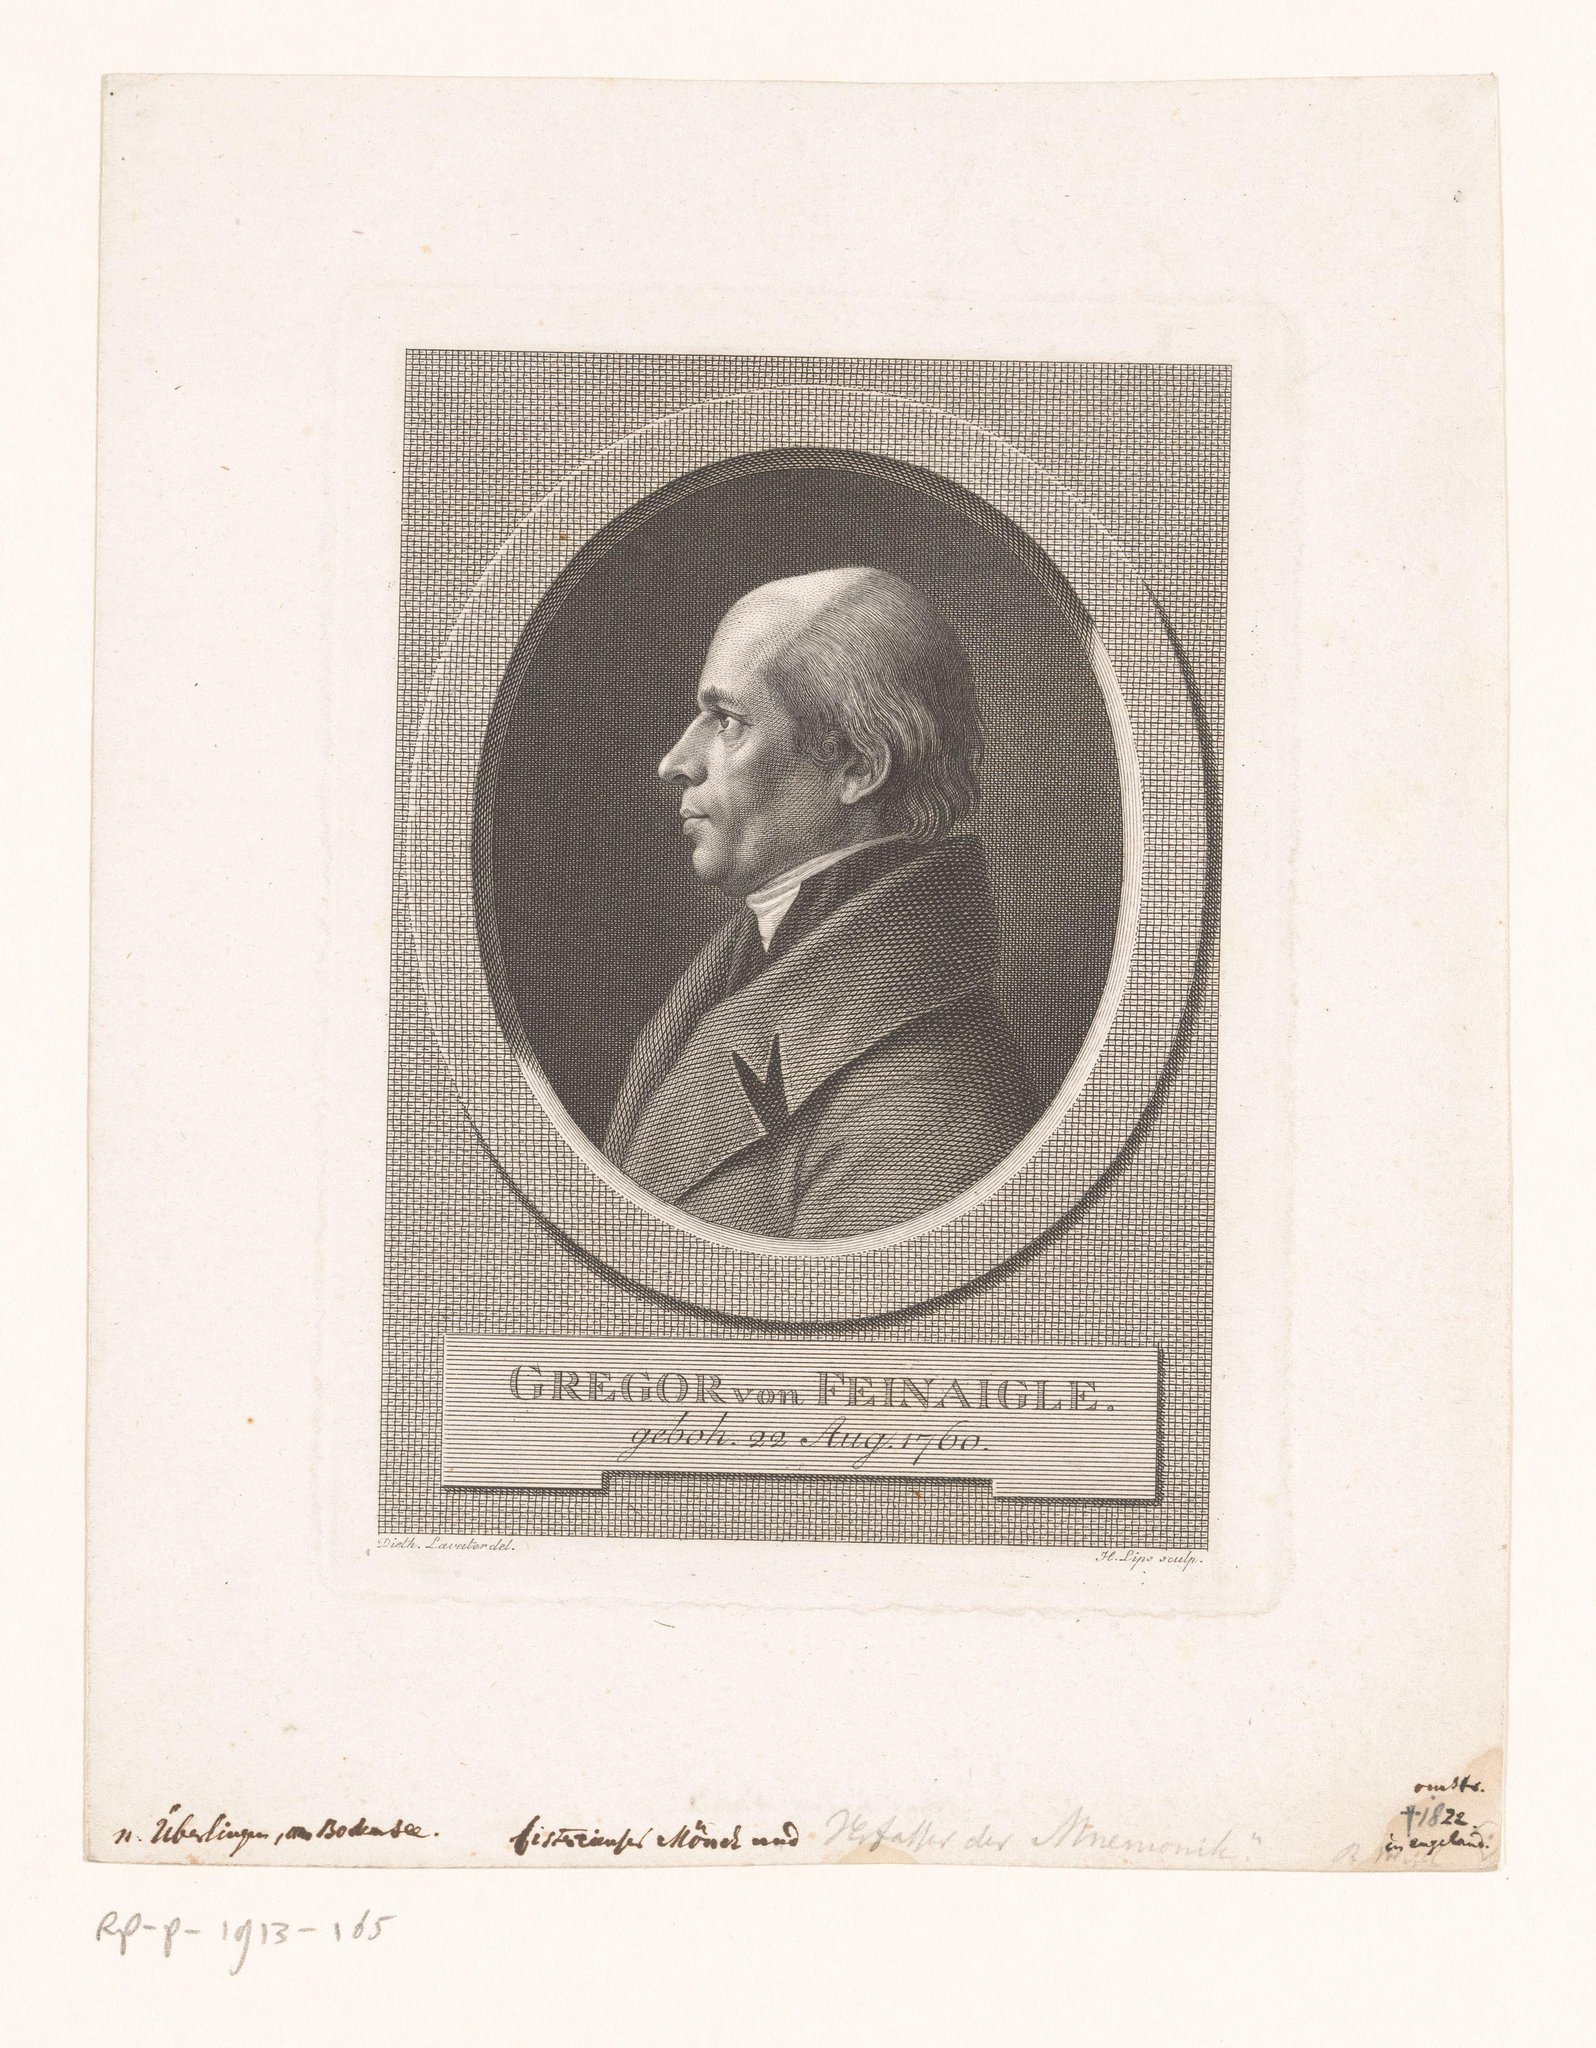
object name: print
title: Portret van Gregor von Feinaigle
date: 1768-1817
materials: paper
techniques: engraving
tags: historical persons, portrait, self-portrait of artist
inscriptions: collector's mark: Lugt 2228